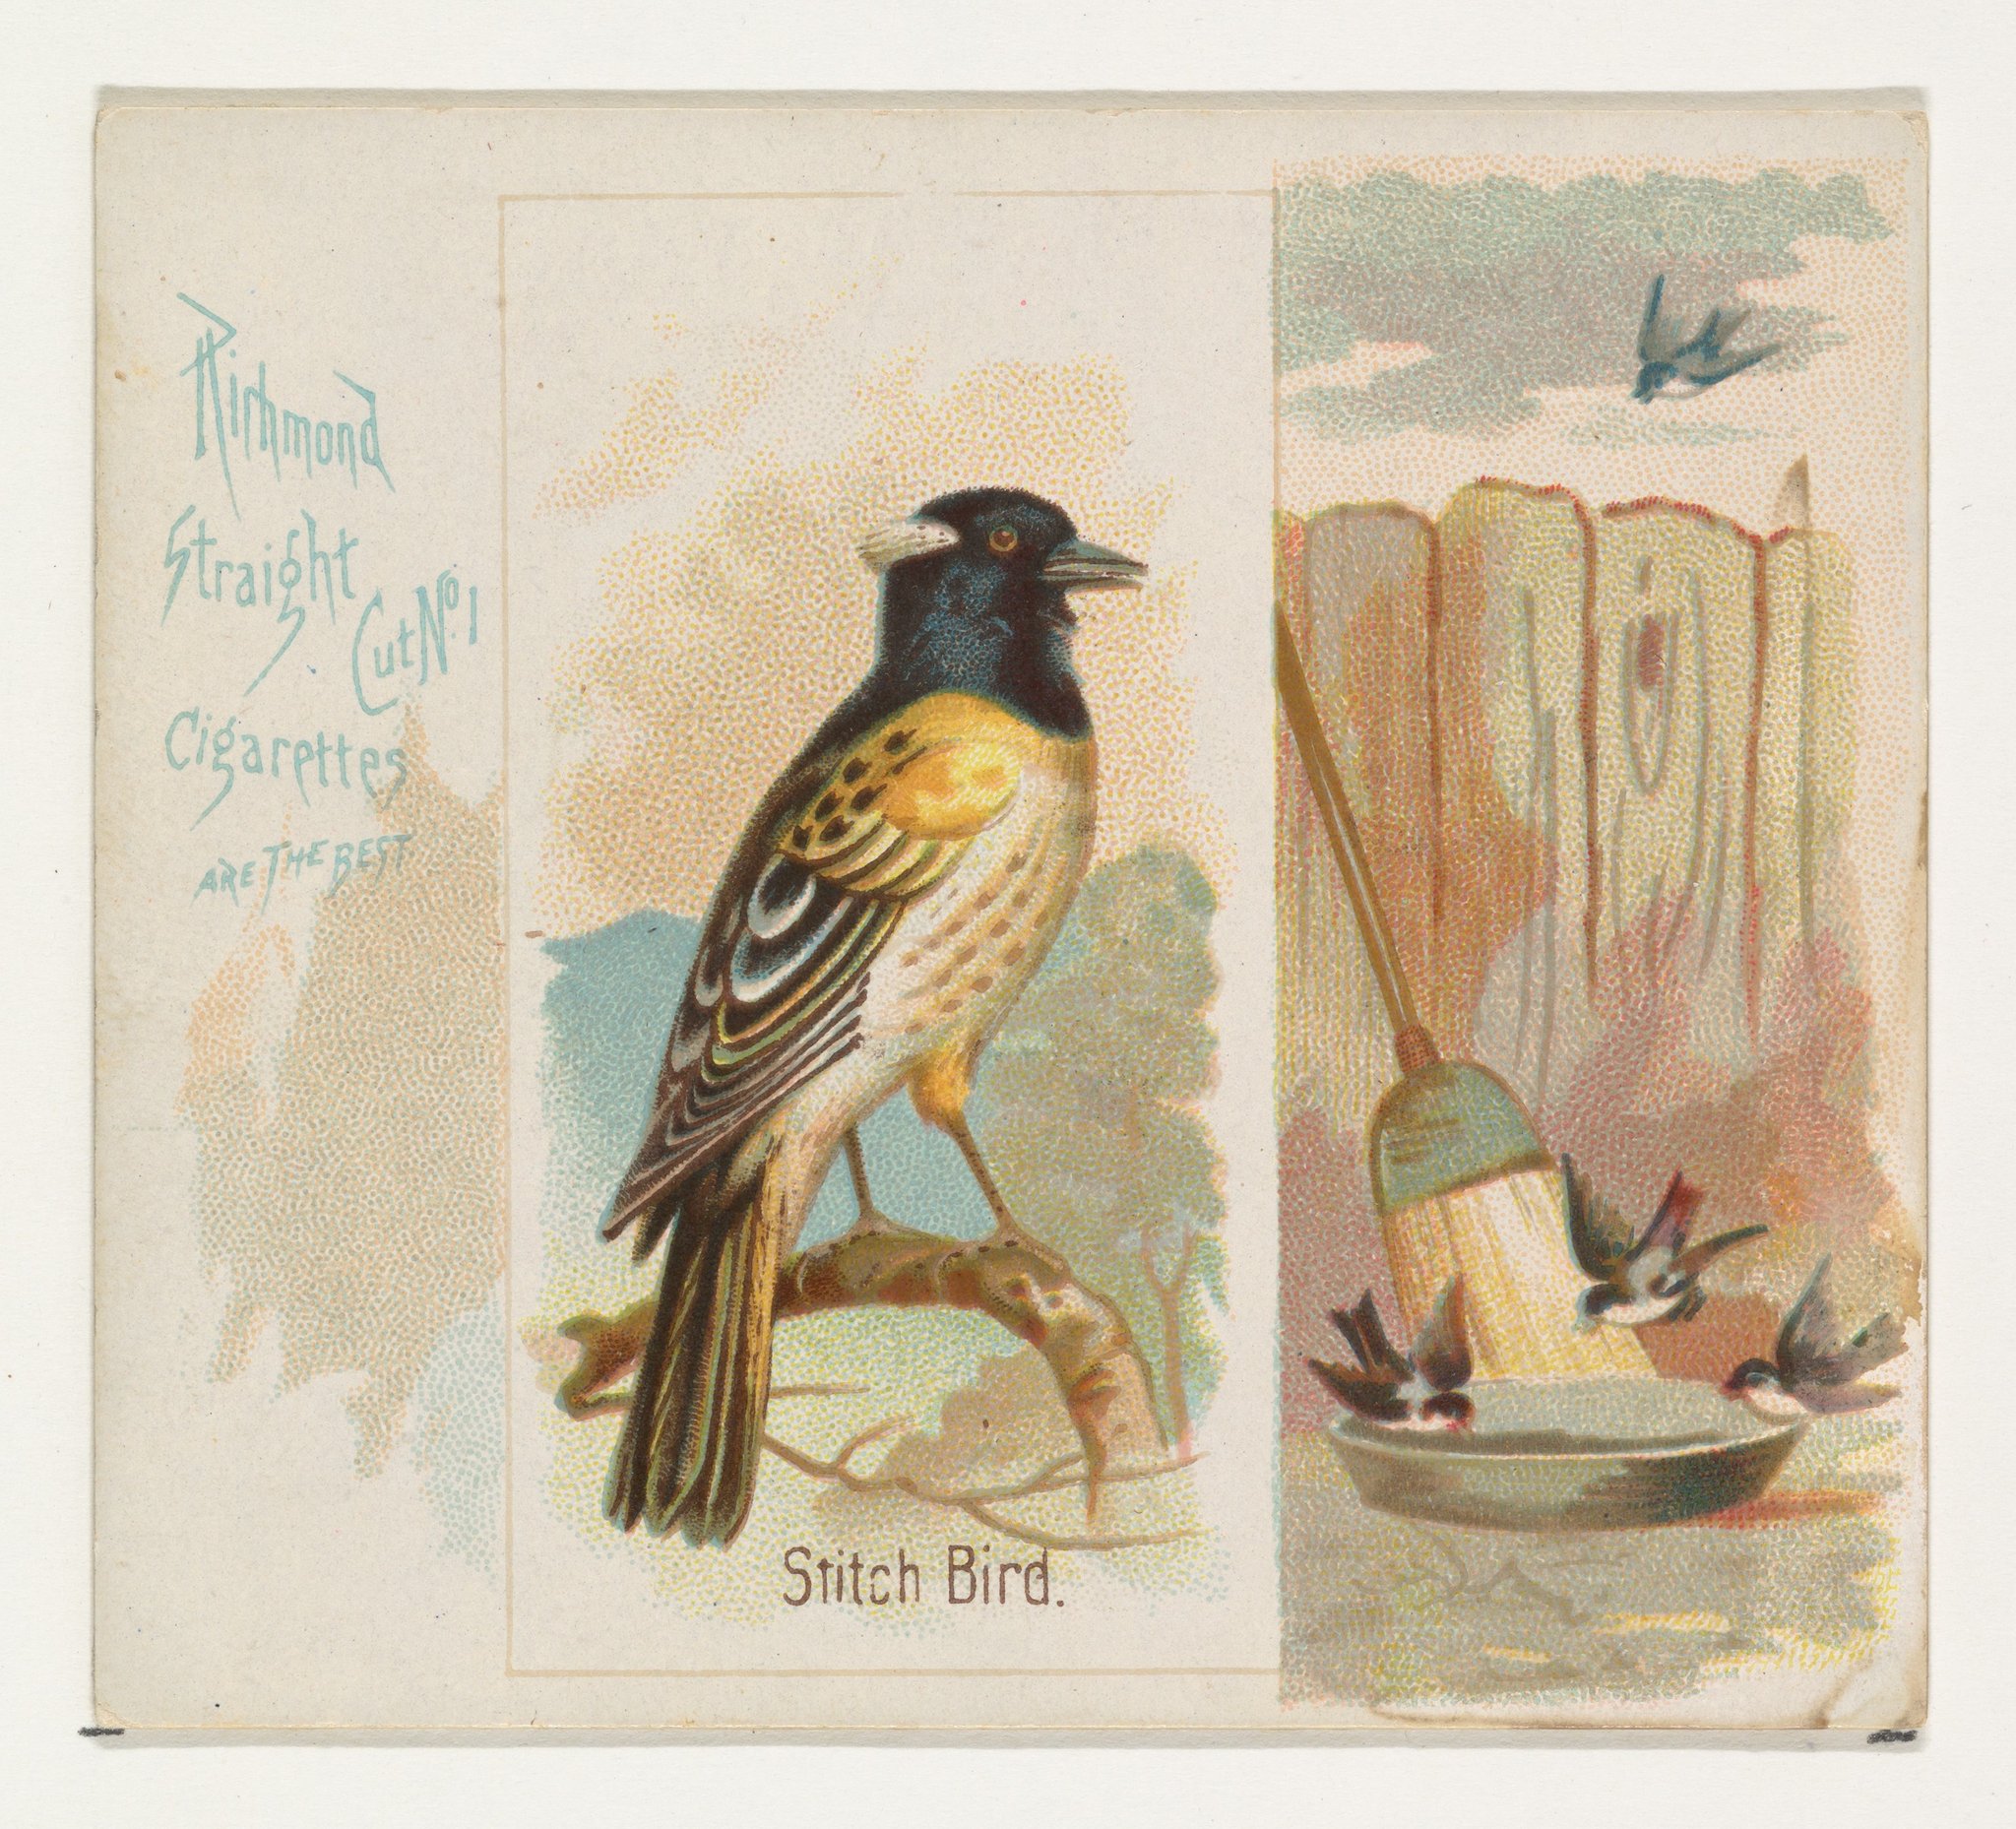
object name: print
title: Stitch Bird, from the Song Birds of the World series (N42) for Allen & Ginter Cigarettes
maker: allen & ginter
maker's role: publisher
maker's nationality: american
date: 1890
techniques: color lithograph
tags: birds